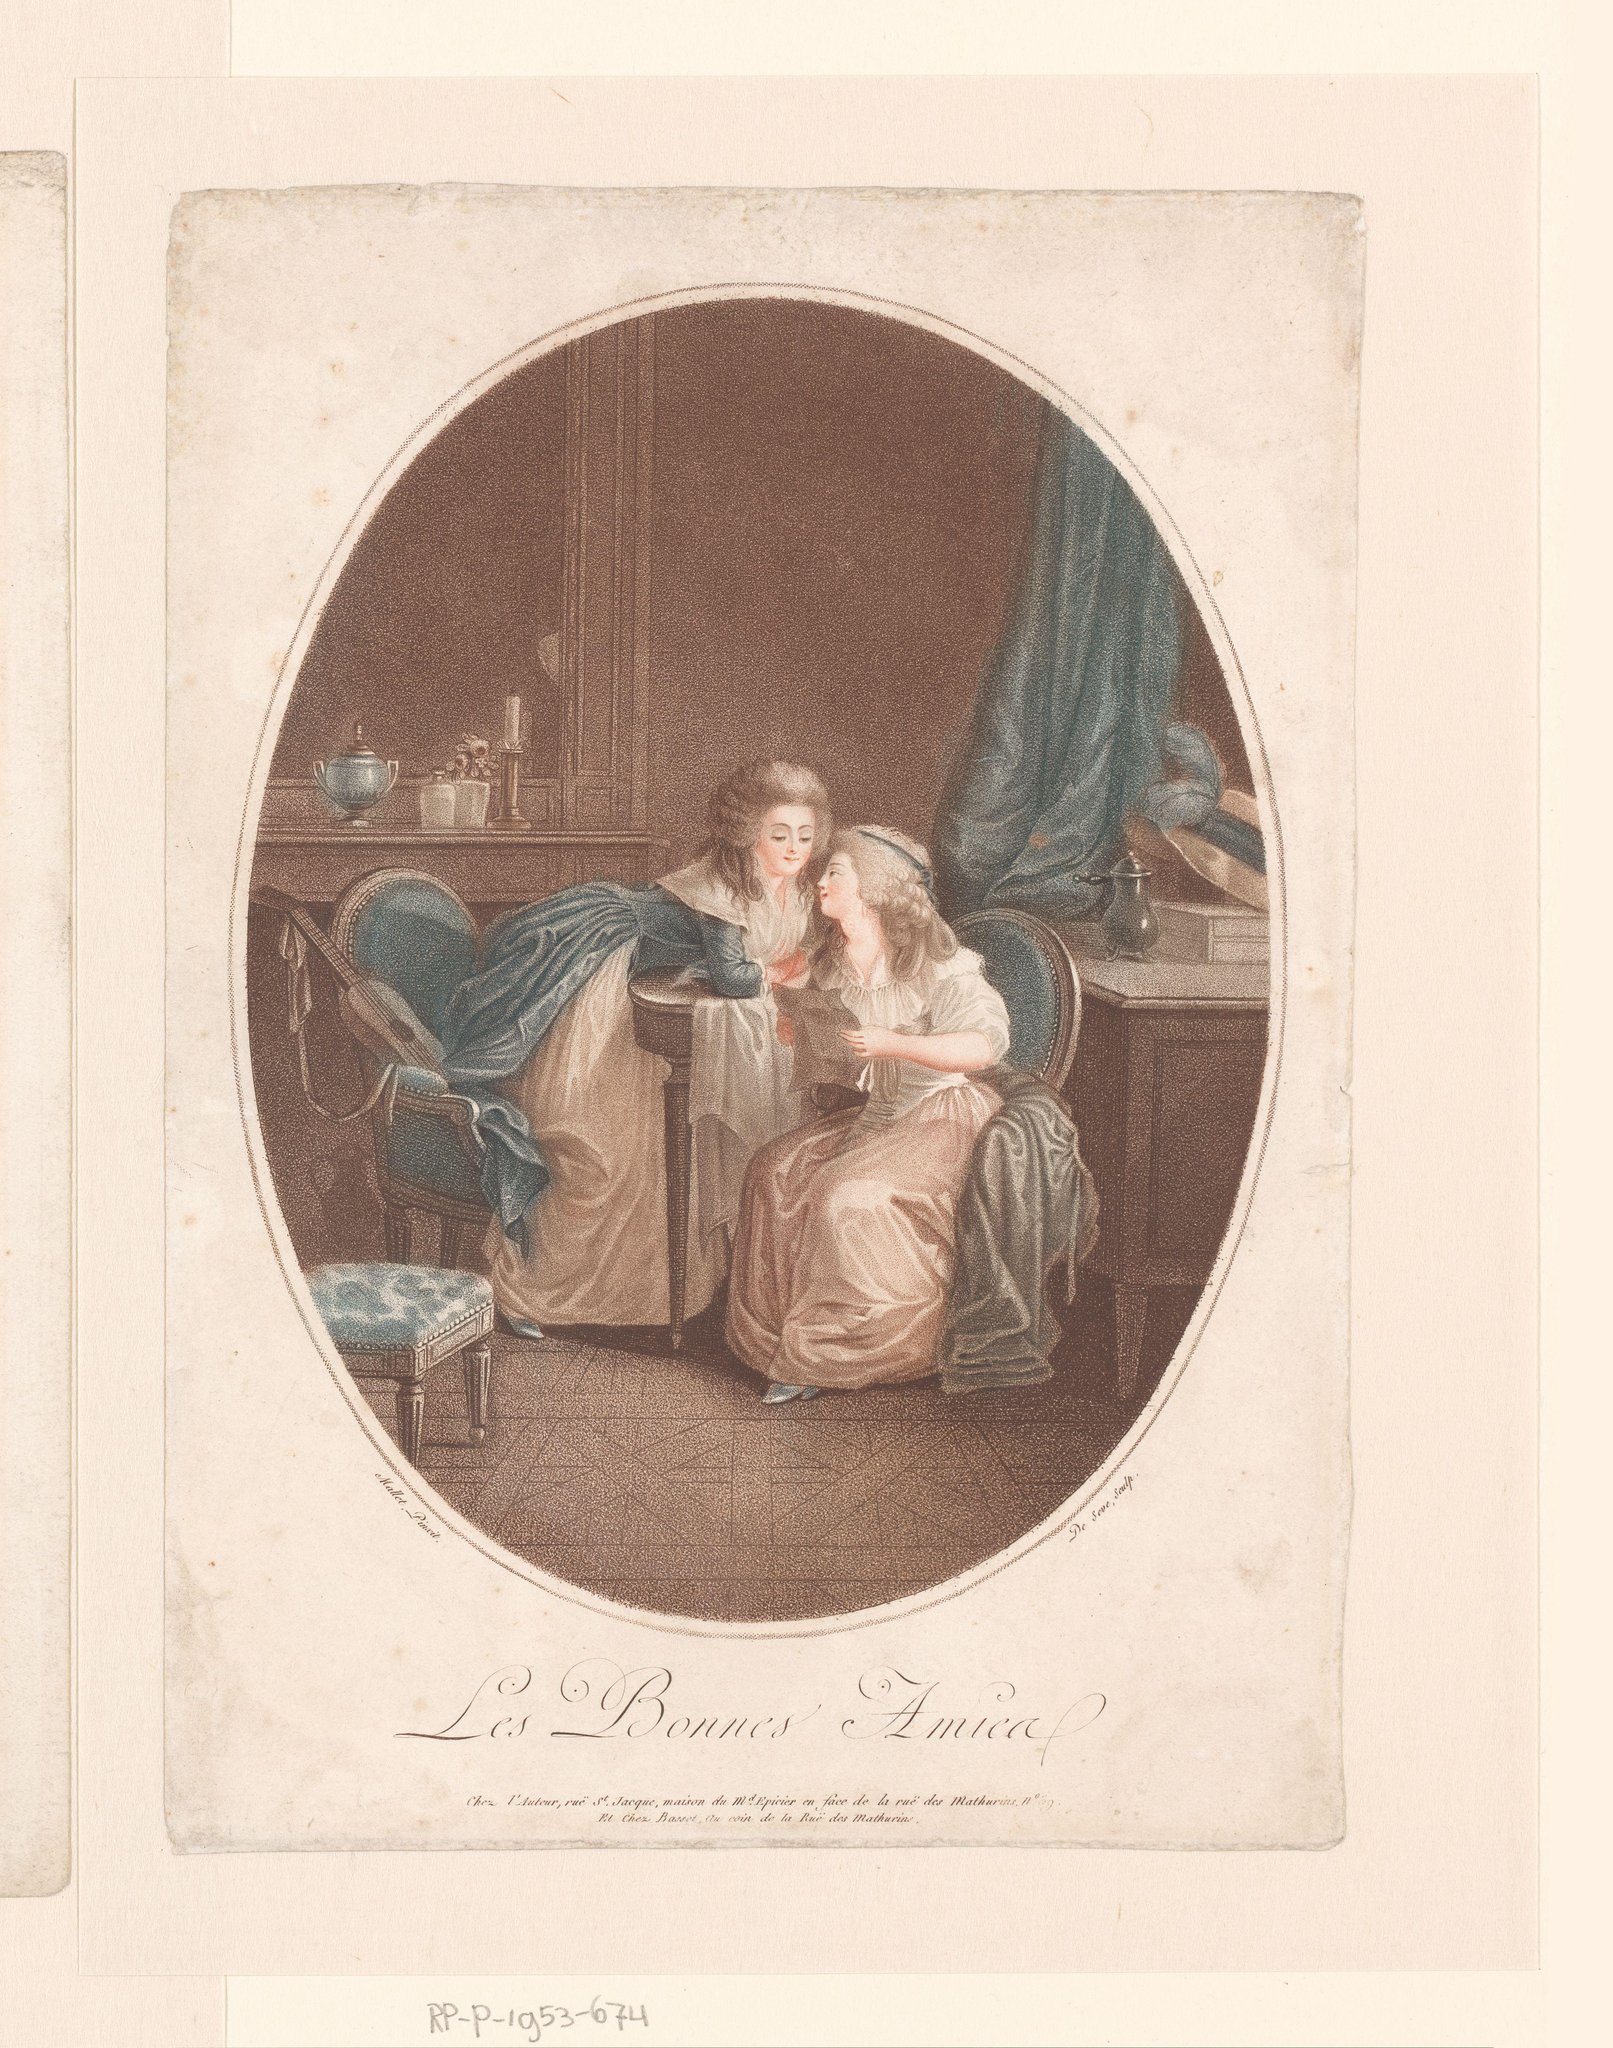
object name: print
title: Interieur met twee elegante dames, samen een brief lezend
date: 1800-1830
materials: paper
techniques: etching, lithography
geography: paris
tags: interior of the house, adult woman (+ two persons)